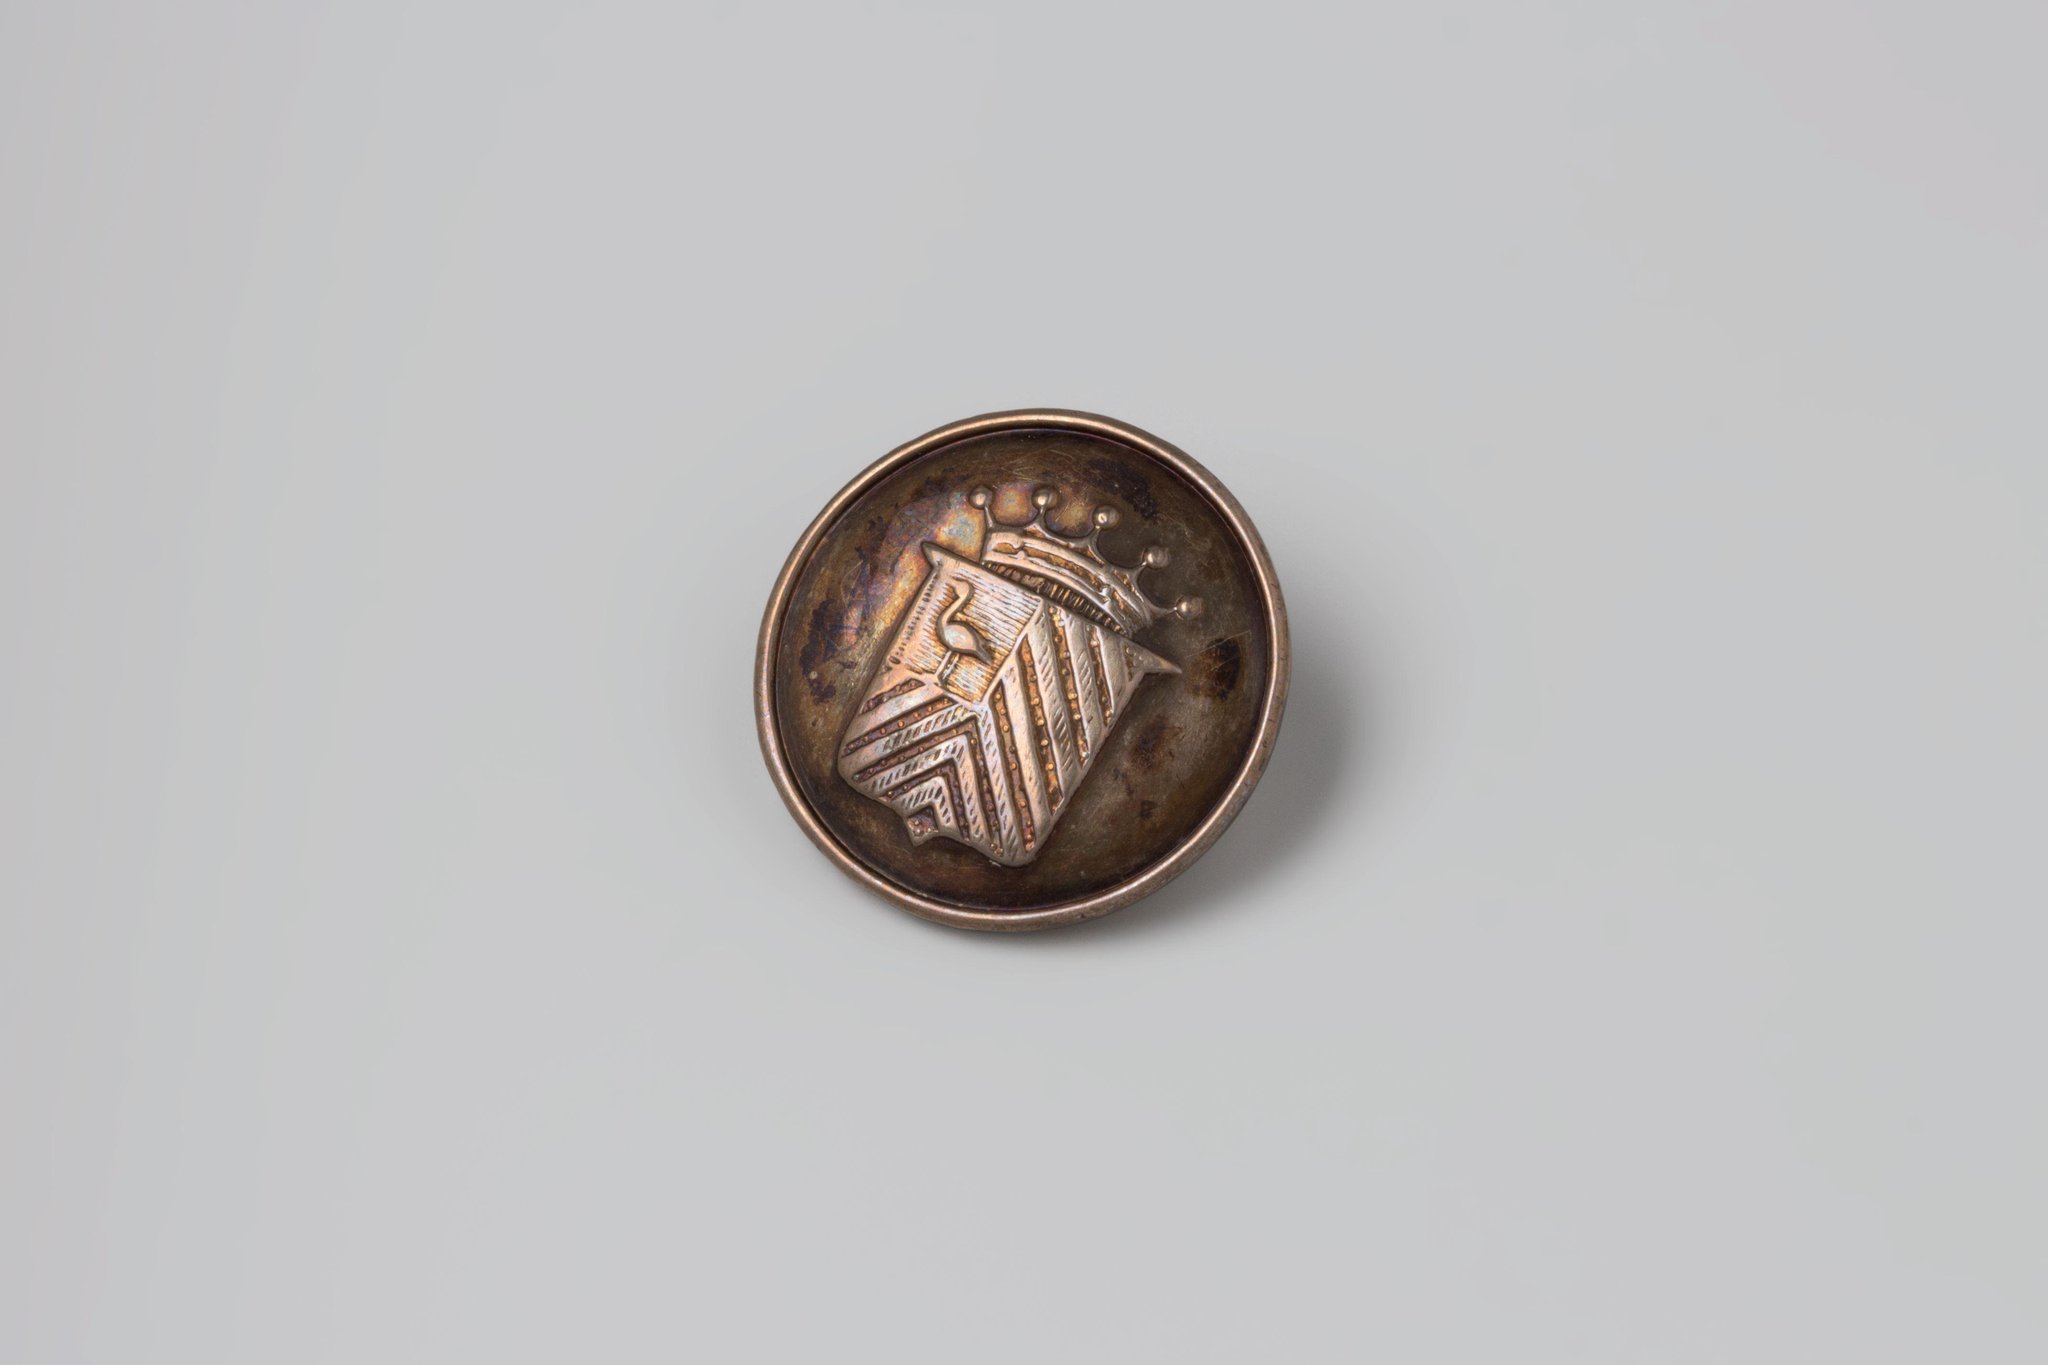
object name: button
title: Livreiknoop van zilver met wapen Teding van Berkhout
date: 1853-1866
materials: copper, silver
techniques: forging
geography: utrecht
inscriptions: company name: ‘'H. de Heus & Z' en 'Utrecht'’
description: Livreiknoop van zilver met wapen Teding van Berkhout. Bolle voorkant waarin het wapen is geslagen. Het wapen Teding van Berkhout (1815): in goud zeven rode kepers, in een blauw vrijkwartier een staande zilveren kraanvogel. Aan de achterkant voorzien van een koperen oog.